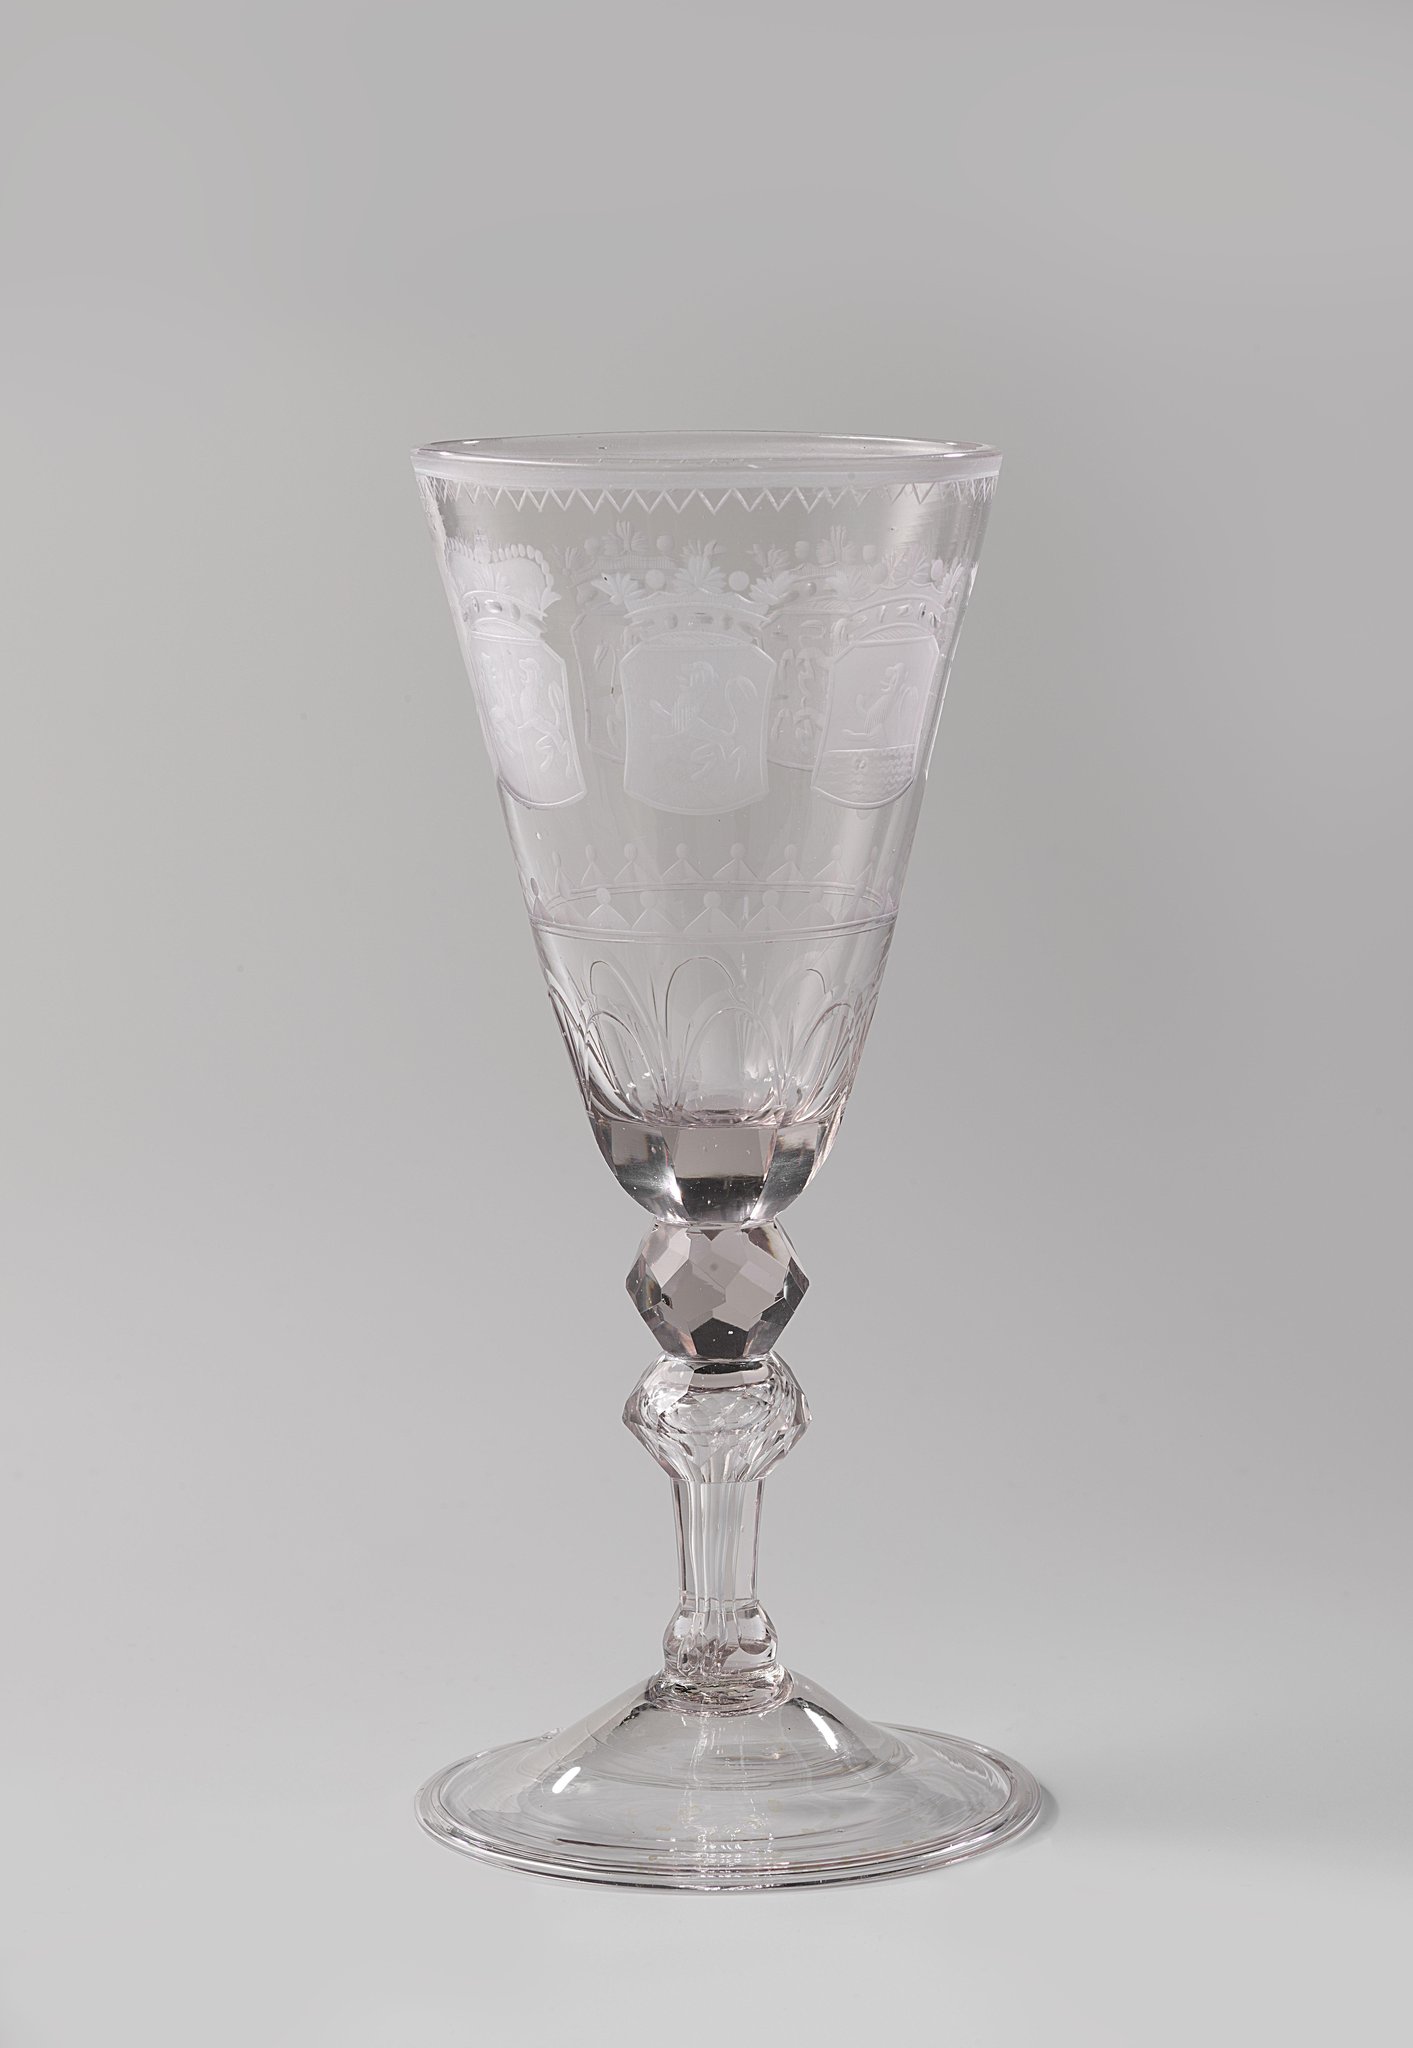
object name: goblet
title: Bokaal met de wapens van de Zeven Verenigde Provinciën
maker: Anonymous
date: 1725-1750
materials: glass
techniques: glassblowing, grinding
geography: northern netherlands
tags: republiek der zeven verenigde nederlanden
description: Bokaal met conische voet, facetgeslepen, balustervormige stam met twee knopen en een verlengde luchtbel. Trechtervormige kelk met facetgeslepen, afgeronde onderzijde. Op de kelk, onder een matte band en een zig-zagrand, zijn de gekroonde wapens van de Zeven Verenigde Provinciën afgebeeld in een doorlopende rij, boven een matte, gekartelde rand, bekroond met bollen.